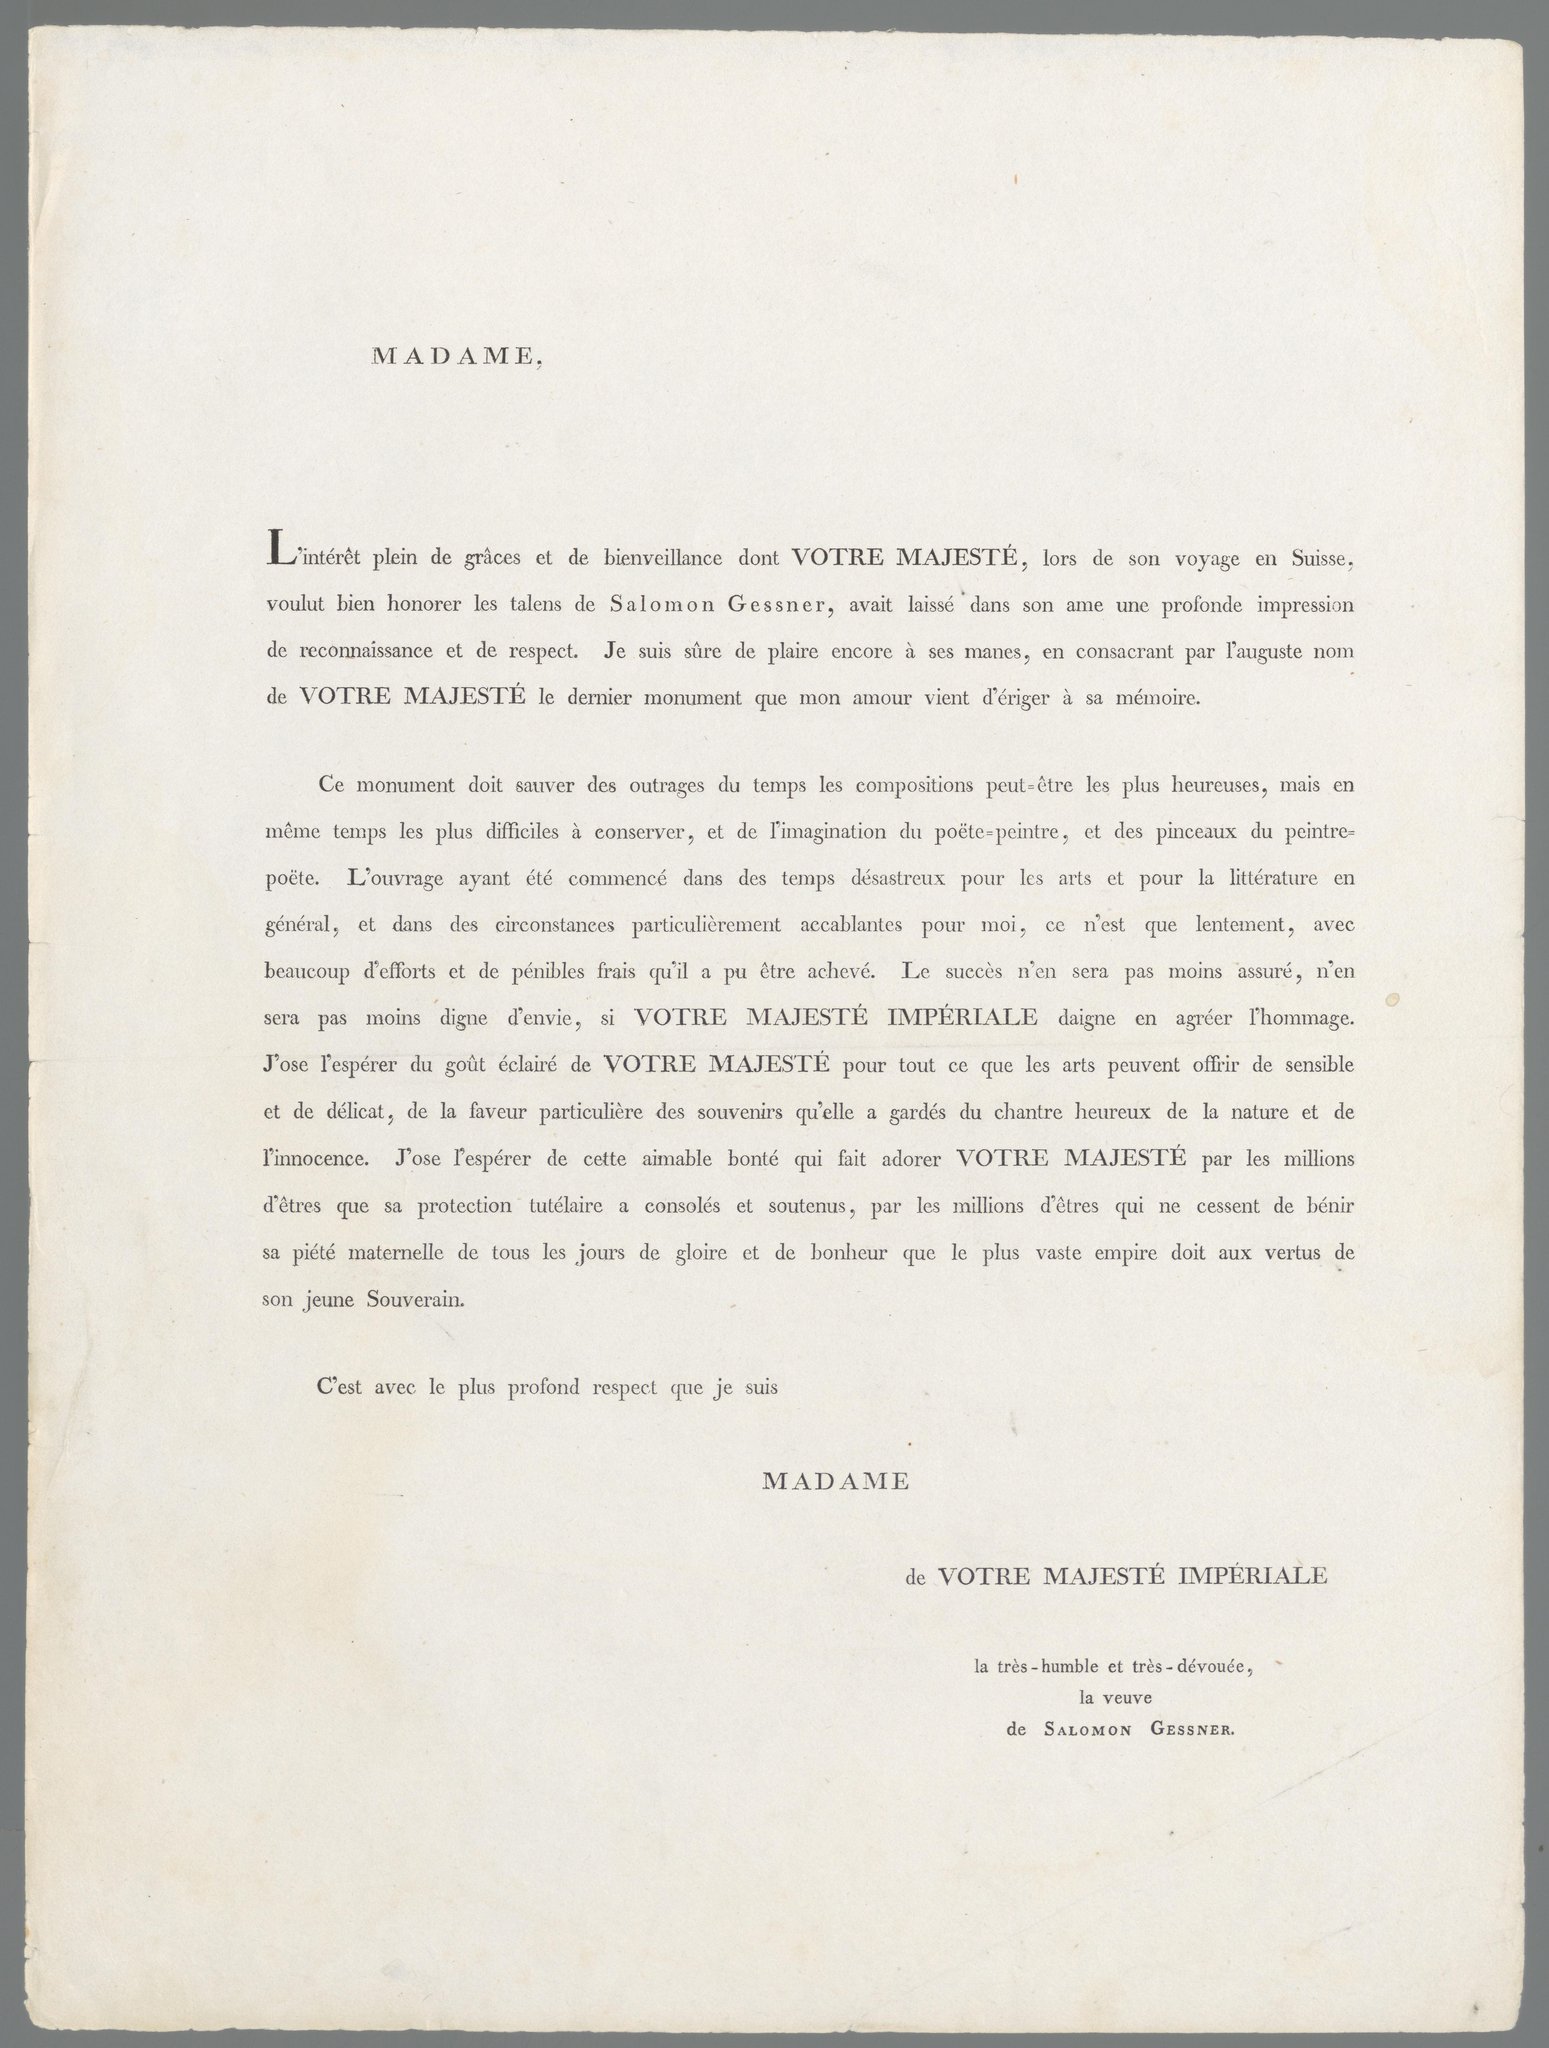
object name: text sheet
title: Tekstblad met de opdracht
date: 1811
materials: paper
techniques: letterpress printing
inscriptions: date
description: De tekst beschrijft waarom de serie van 27 prenten is opgedragen aan 'Madame de vostre Majesté Impériale' (keizerin van Rusland) geschreven door de weduwe van Salomon Gessner. Dit tekstblad maakt deel uit van een omslag met 27 losse bladen, waarvan 25 prenten, een titelblad en een tekstblad.